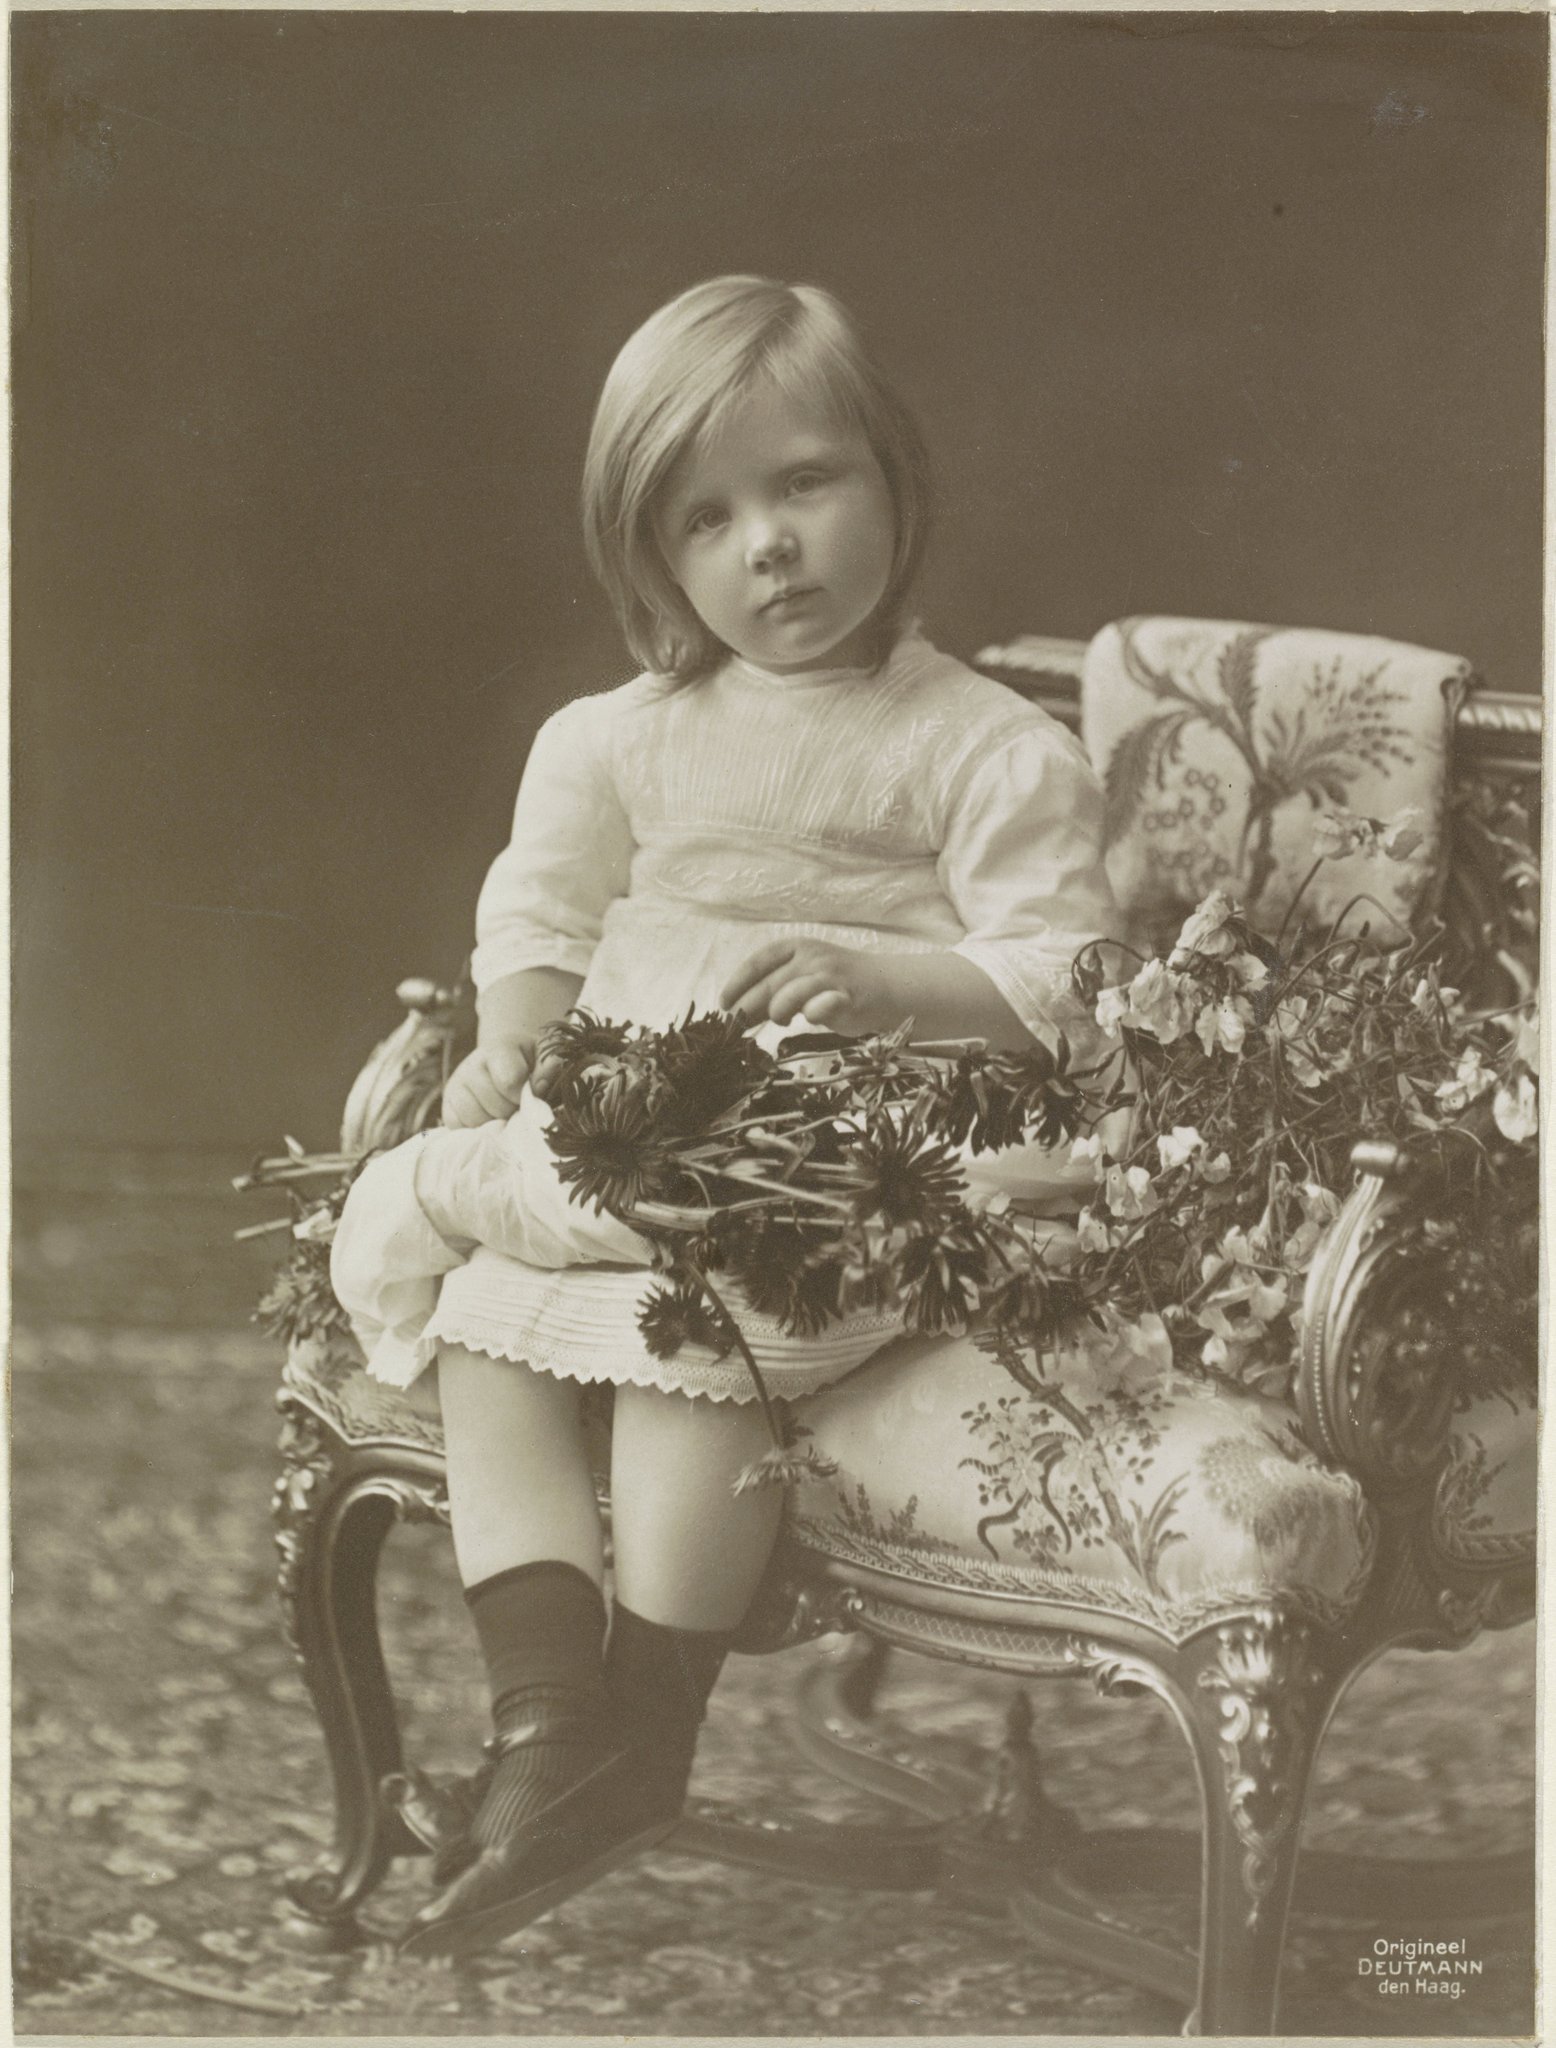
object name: photograph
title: Portret van Juliana, koningin der Nederlanden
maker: herman deutmann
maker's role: fotograaf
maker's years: 1870-1926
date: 1911-1913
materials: photographic support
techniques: photography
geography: the hague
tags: juliana of the netherlands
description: De hier vermelde titel verwijst naar de hoogst verkregen titel van de geportretteerde, niet per se naar de titel die de geportretteerde op deze voorstelling draagt.